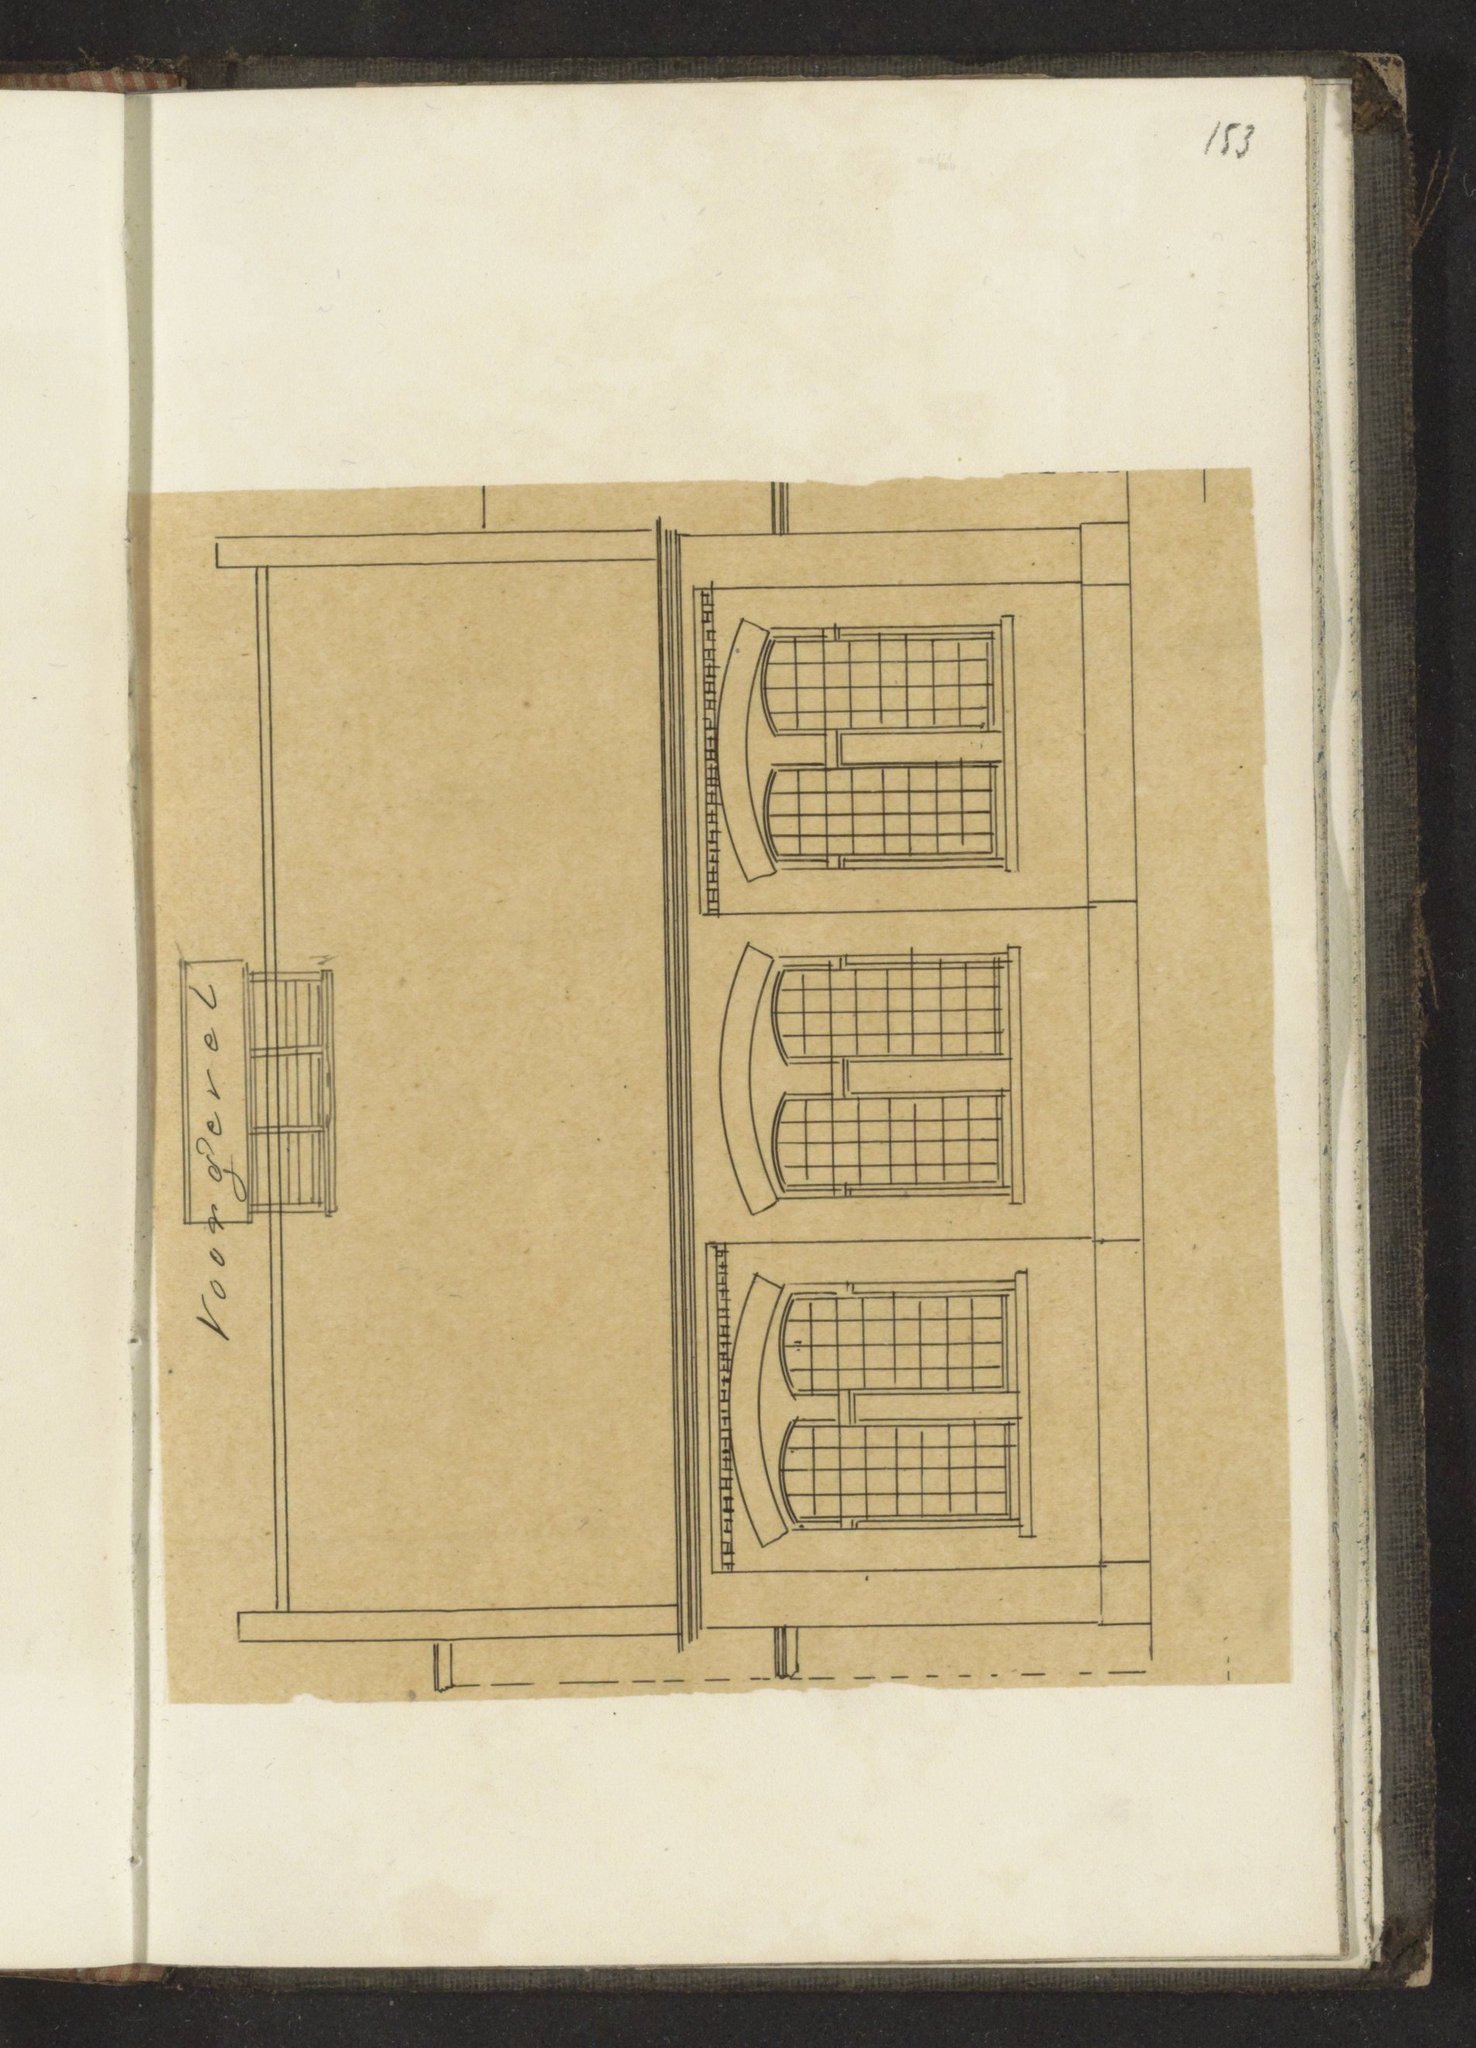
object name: sketchbook leaf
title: Opstand van de voorgevel van een gebouw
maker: willem springer jr.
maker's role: draughtsman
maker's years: 1815-1907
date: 1864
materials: ink, paper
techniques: pen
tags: façade (of house or building)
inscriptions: annotation: ‘voorgevel’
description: Pagina 153 uit een schetsboek met 164 pagina's.